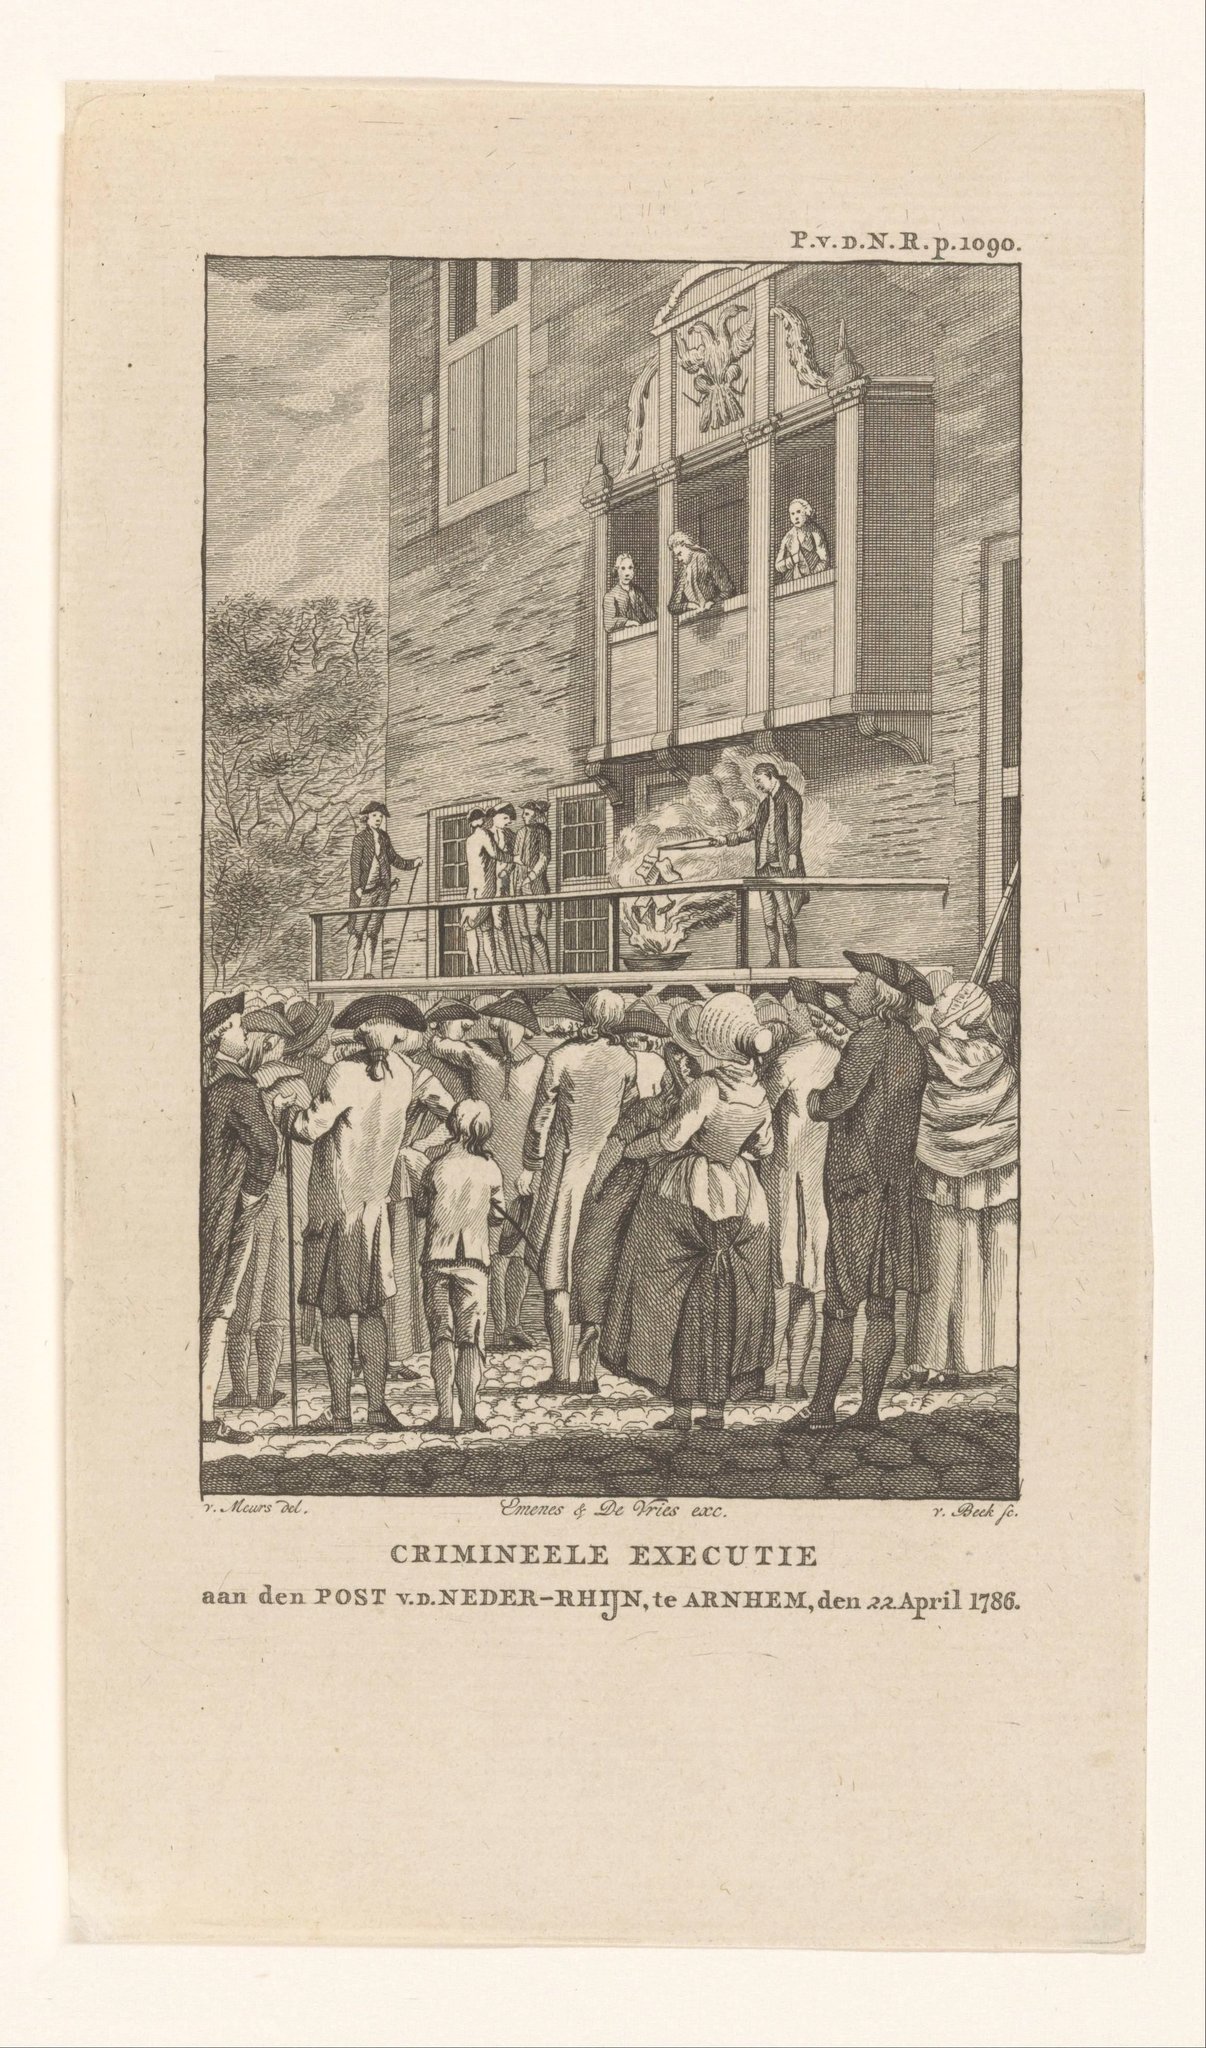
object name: print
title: Verbranding van De Post van de Neder-Rhijn op schavot voor stadhuis te Arnhem op 22 april 1786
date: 1786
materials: paper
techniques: etching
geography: amsterdam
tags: law and jurisprudence (+ place of execution), burning of books, arnhem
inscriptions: collector's mark: Lugt 4780, collector's mark: Lugt 2228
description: Openbare executie door verbranding door een beul van een exemplaar van het patriotse tijdschrift De Post van den Neder-Rhijn, op een schavot voor het oude stadhuis van Arnhem, 22 april 1786. Actie door tegenstanders van het blad waarin de vrijlating van de van moord beschuldigde korporaal van Douglas werd veroordeeld.